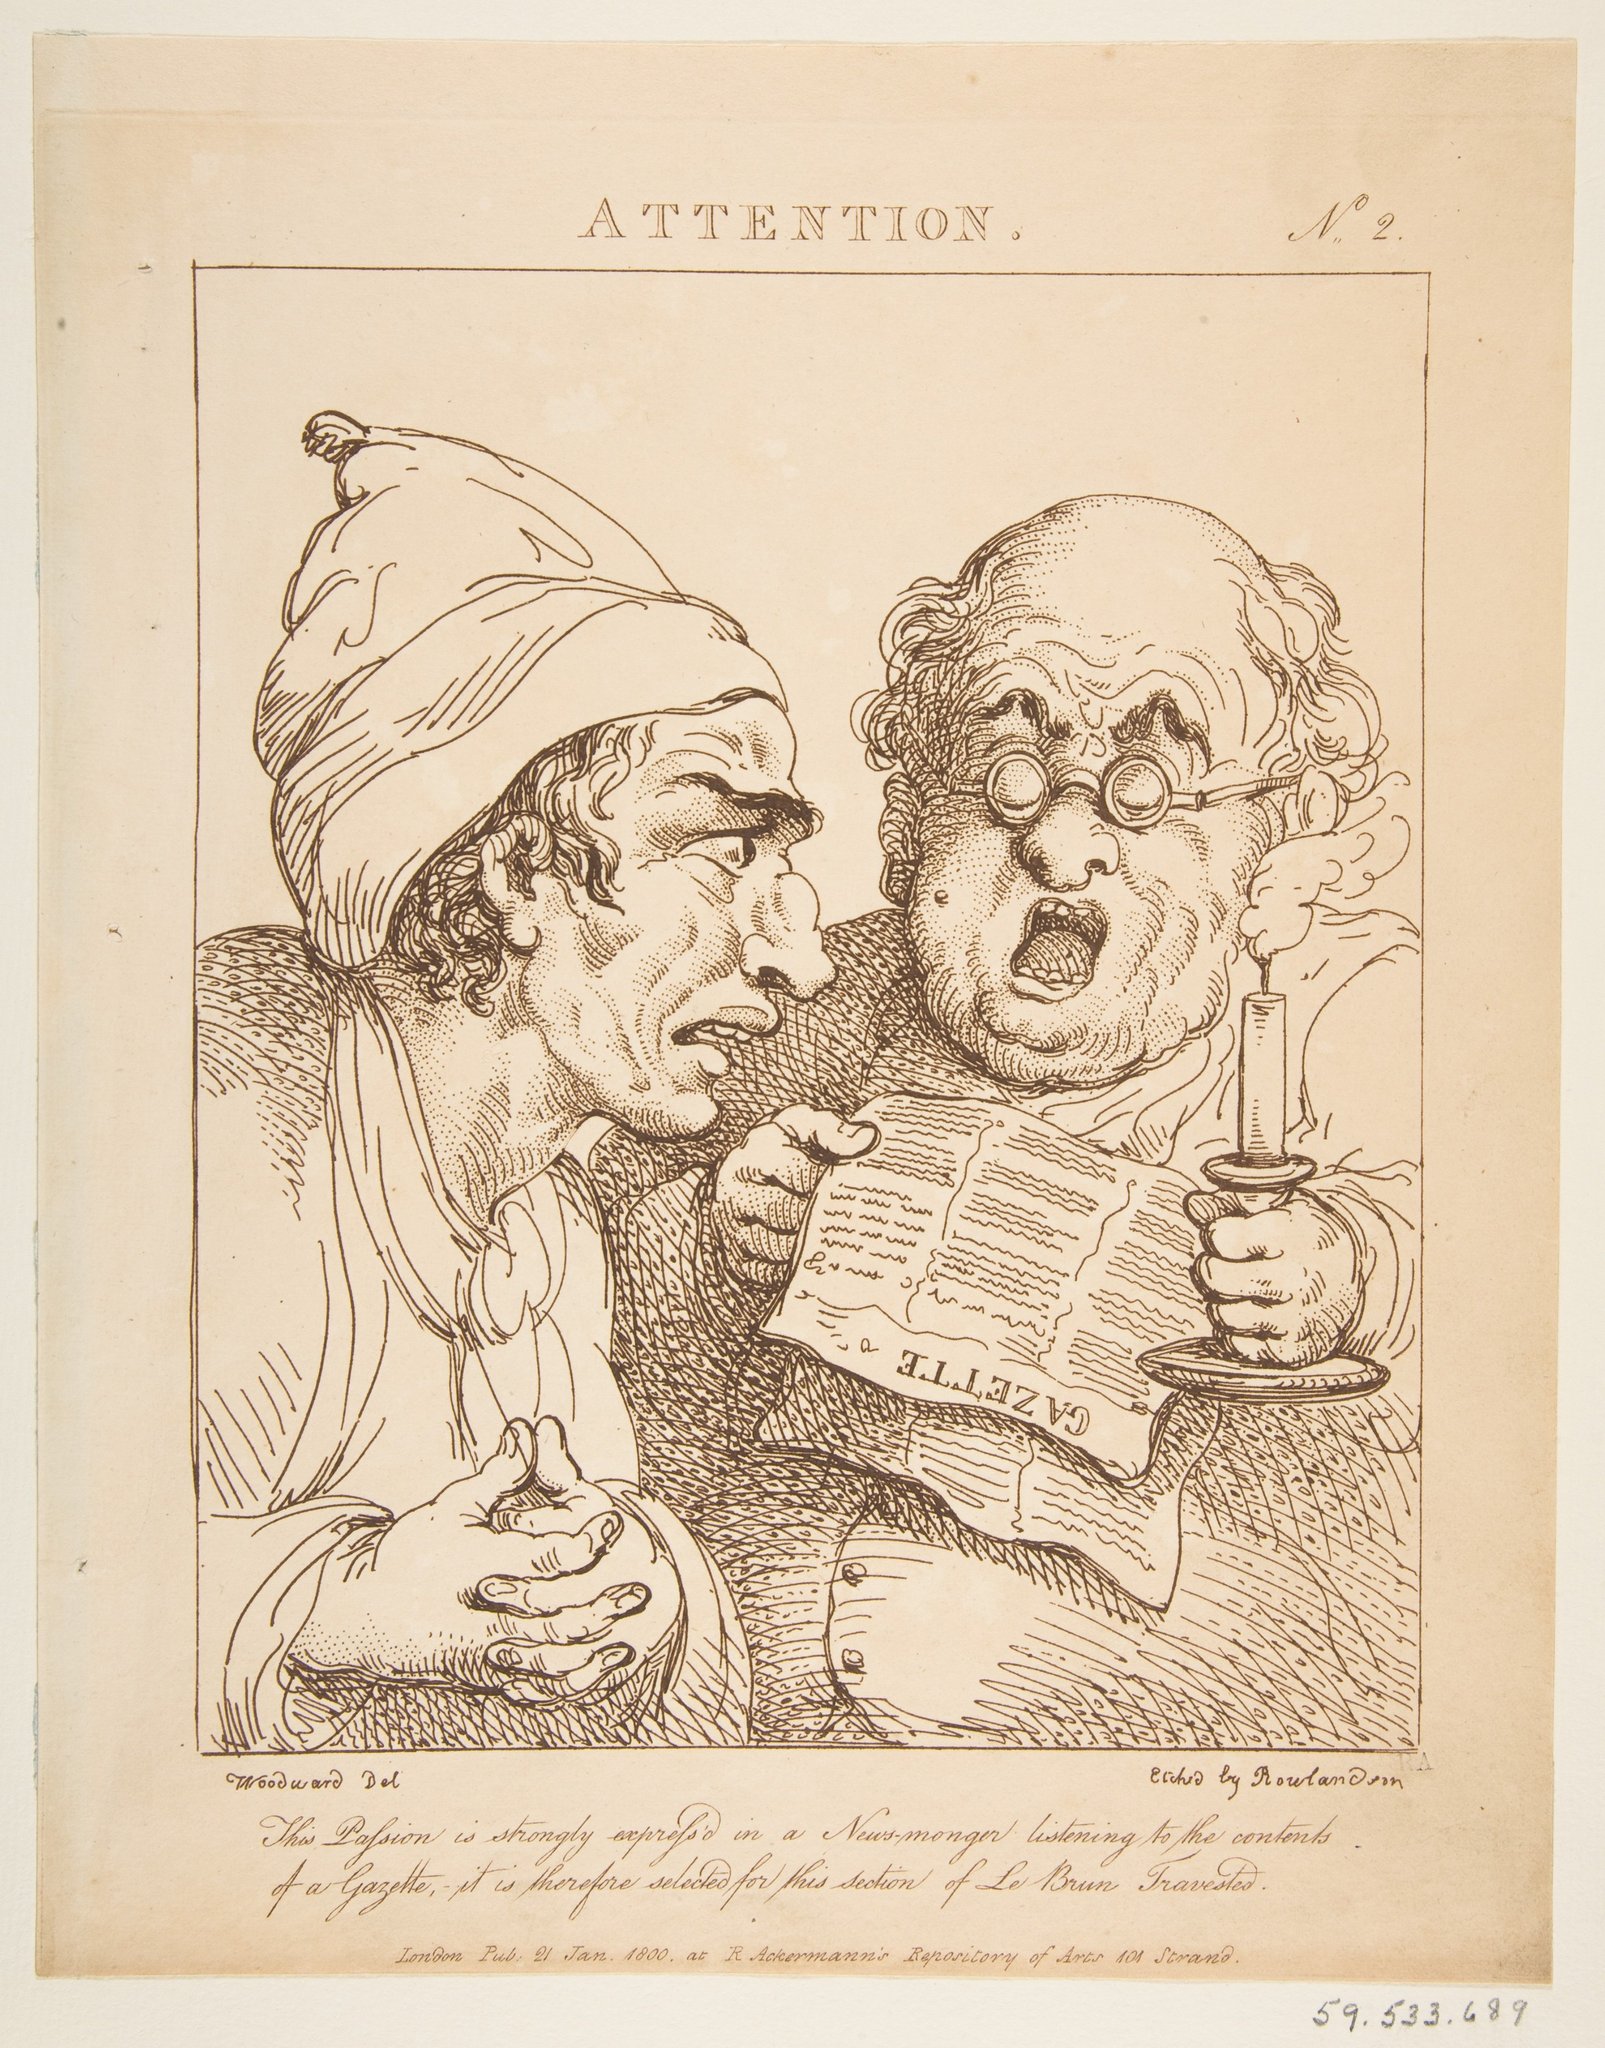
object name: print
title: Attention (Le Brun Travested, or Caricatures of the Passions)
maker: thomas rowlandson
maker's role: artist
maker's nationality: british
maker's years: 1757-1827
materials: ink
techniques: etching, printing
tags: satire,men